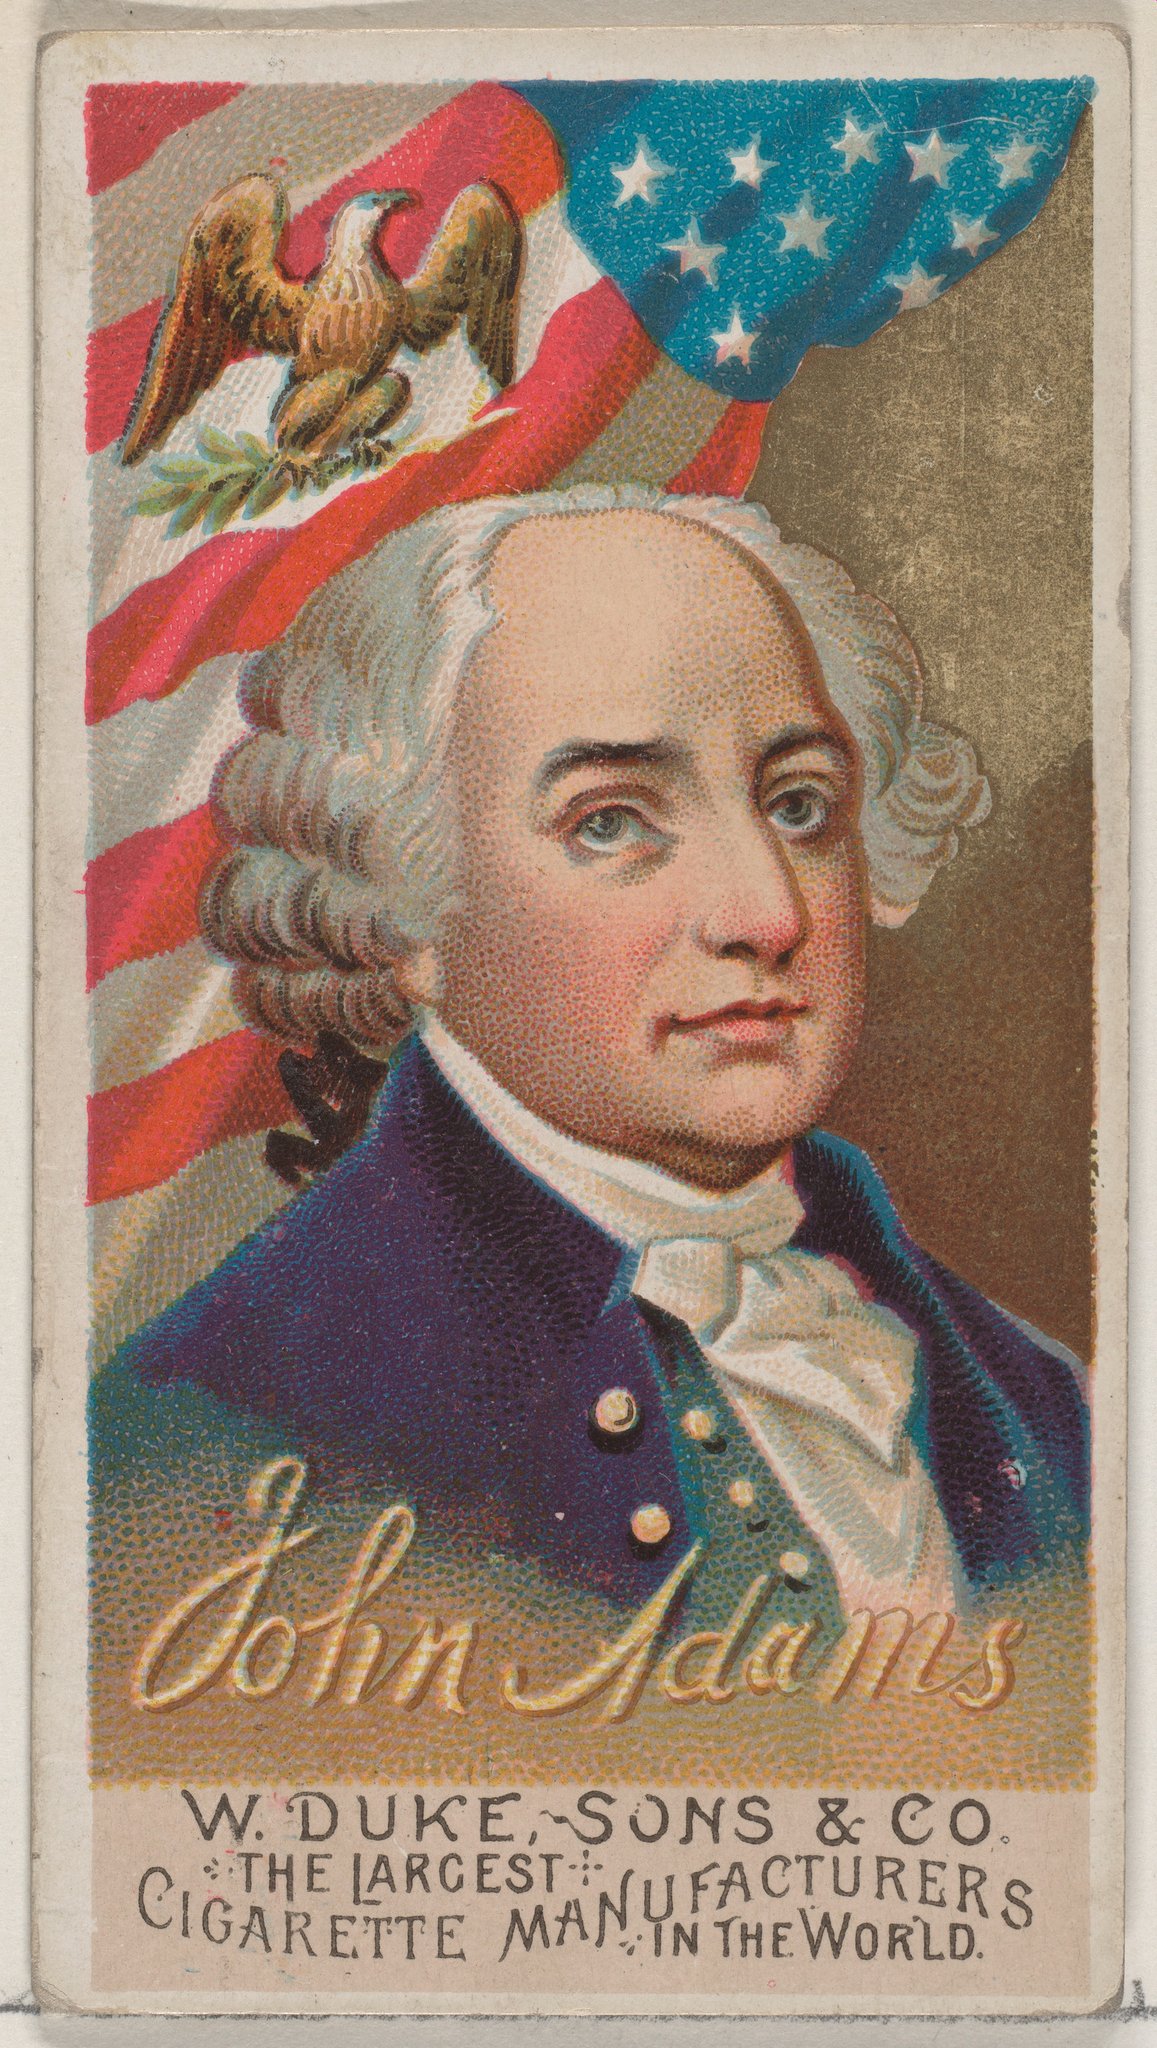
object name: print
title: John Adams, from the series Great Americans (N76) for Duke brand cigarettes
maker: w. duke, sons & co.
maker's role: publisher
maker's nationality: american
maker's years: 1870-1920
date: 1888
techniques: color lithograph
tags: men